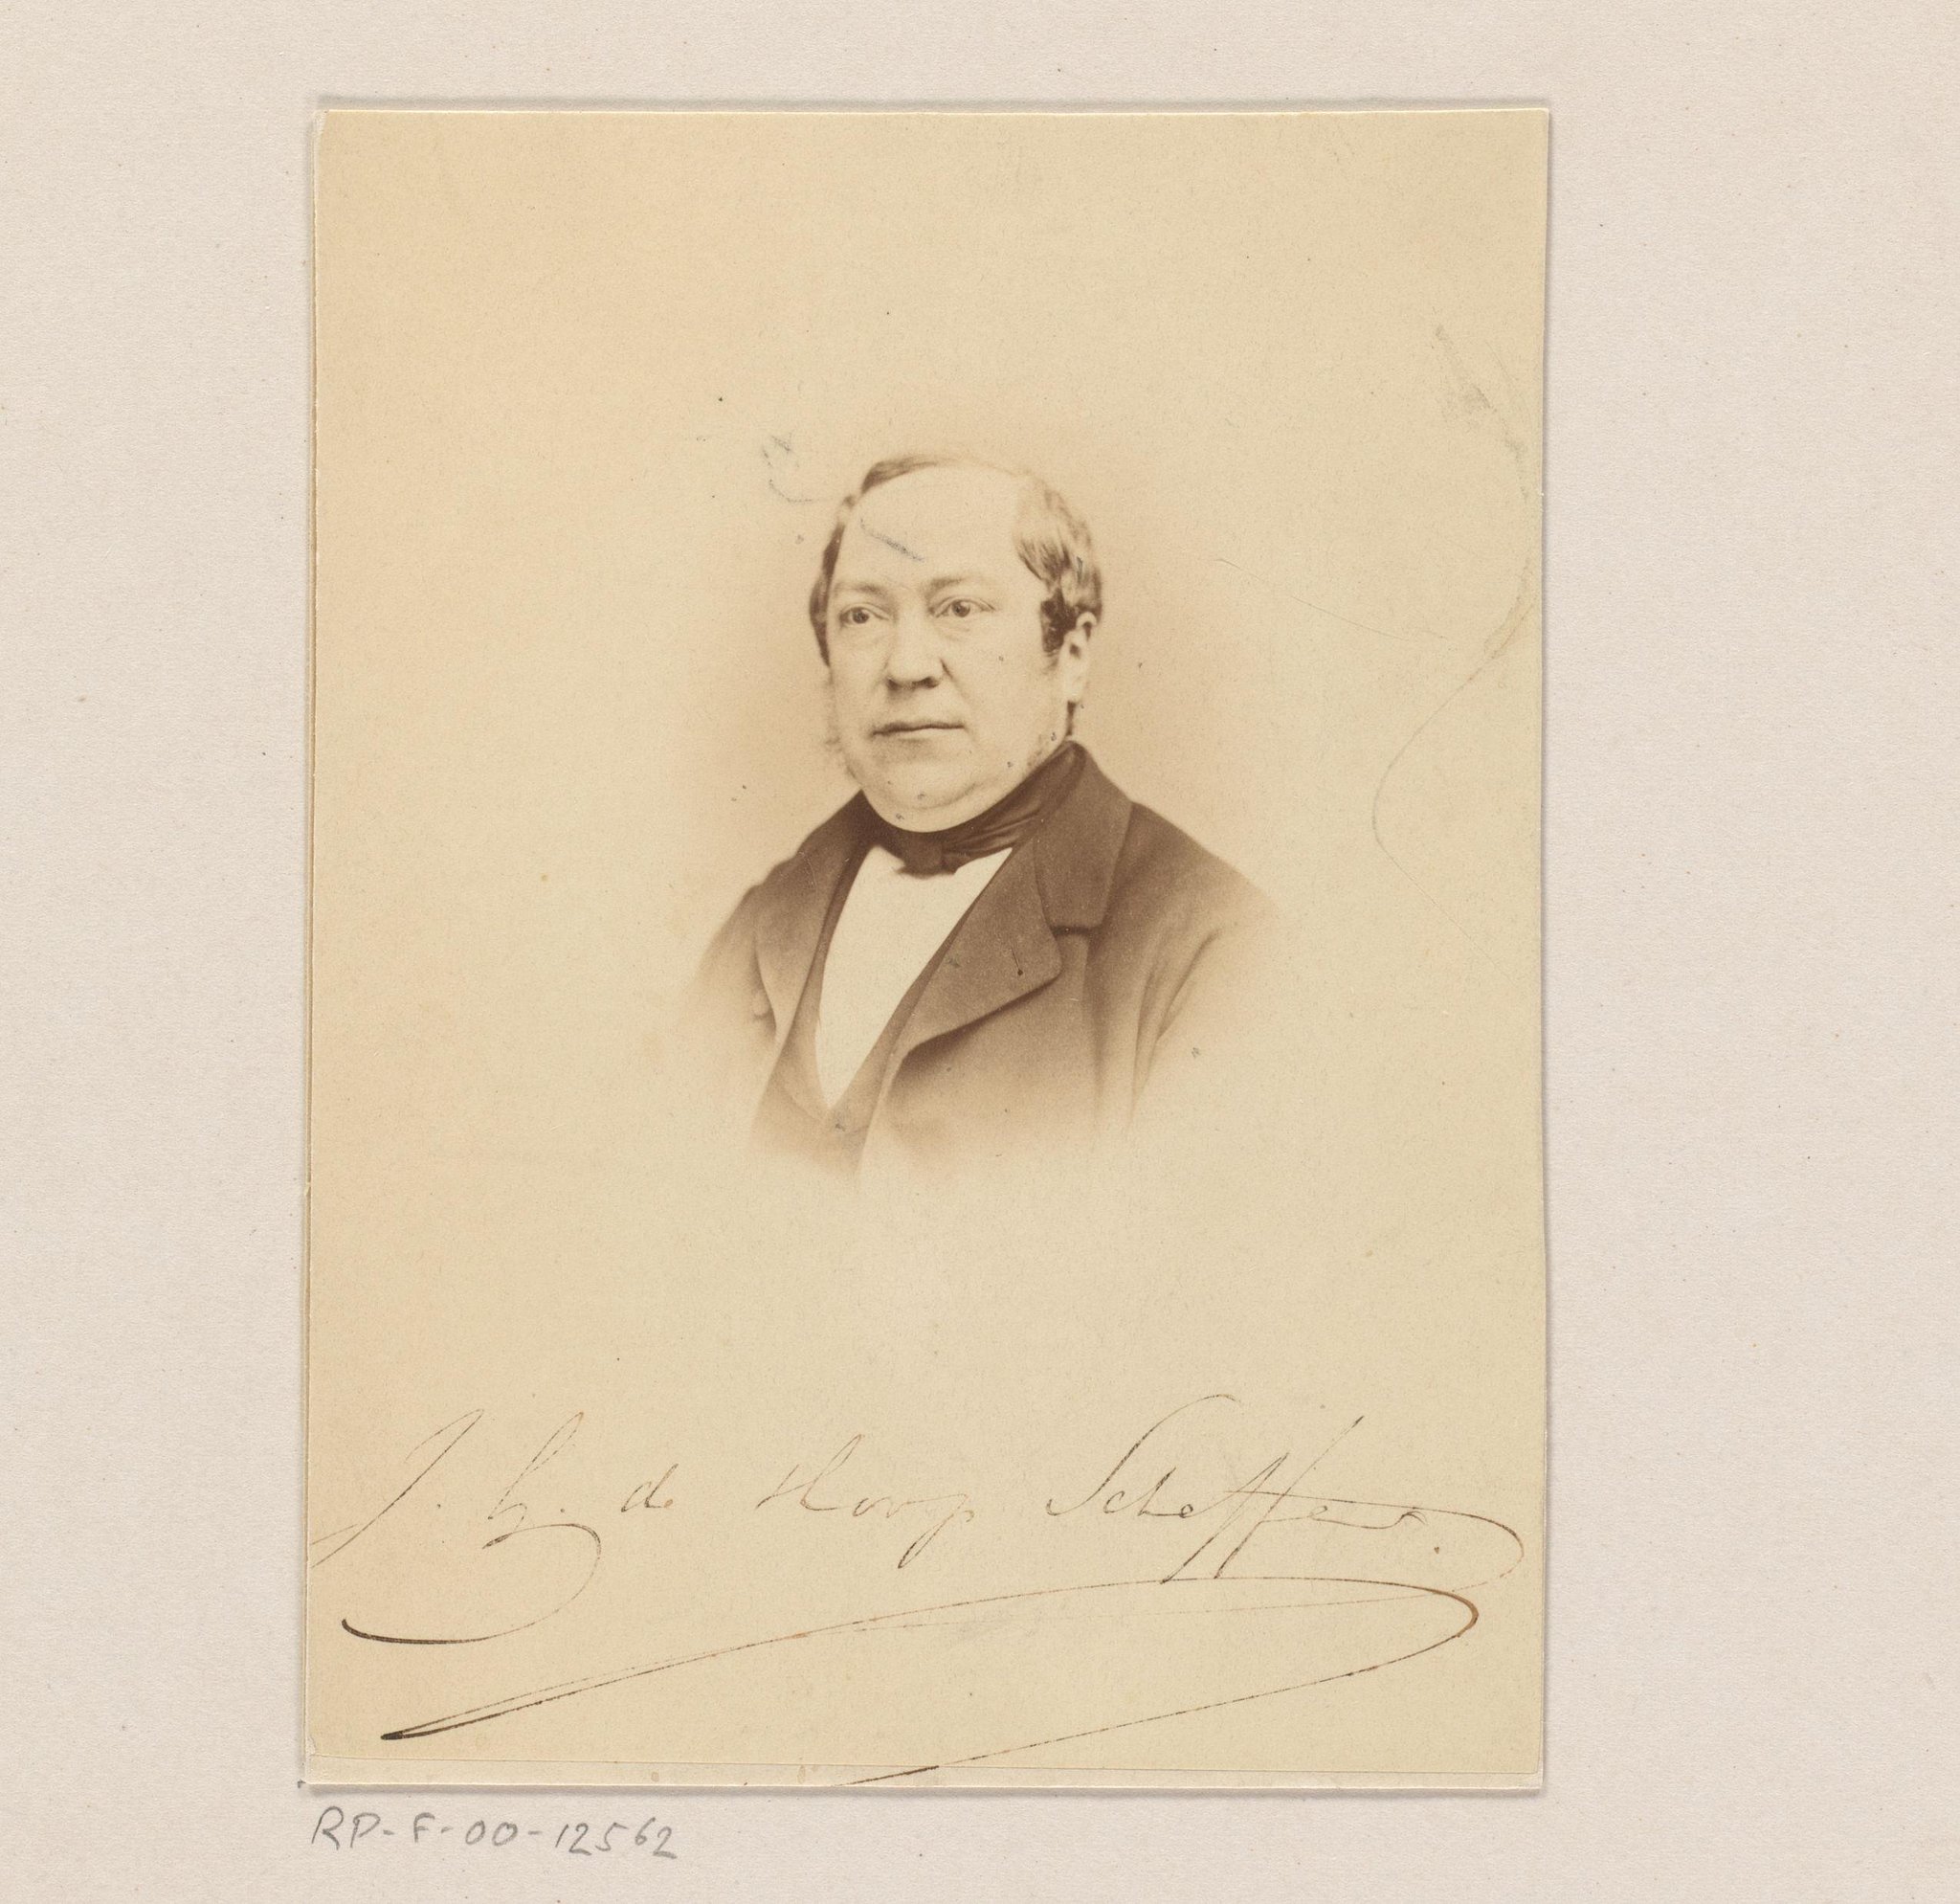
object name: photograph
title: Portret van Jacob Gijsbert de Hoop Scheffer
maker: Anonymous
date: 1860-1890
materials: cardboard, paper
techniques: albumen print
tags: the hague, historical persons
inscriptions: number: ‘3’